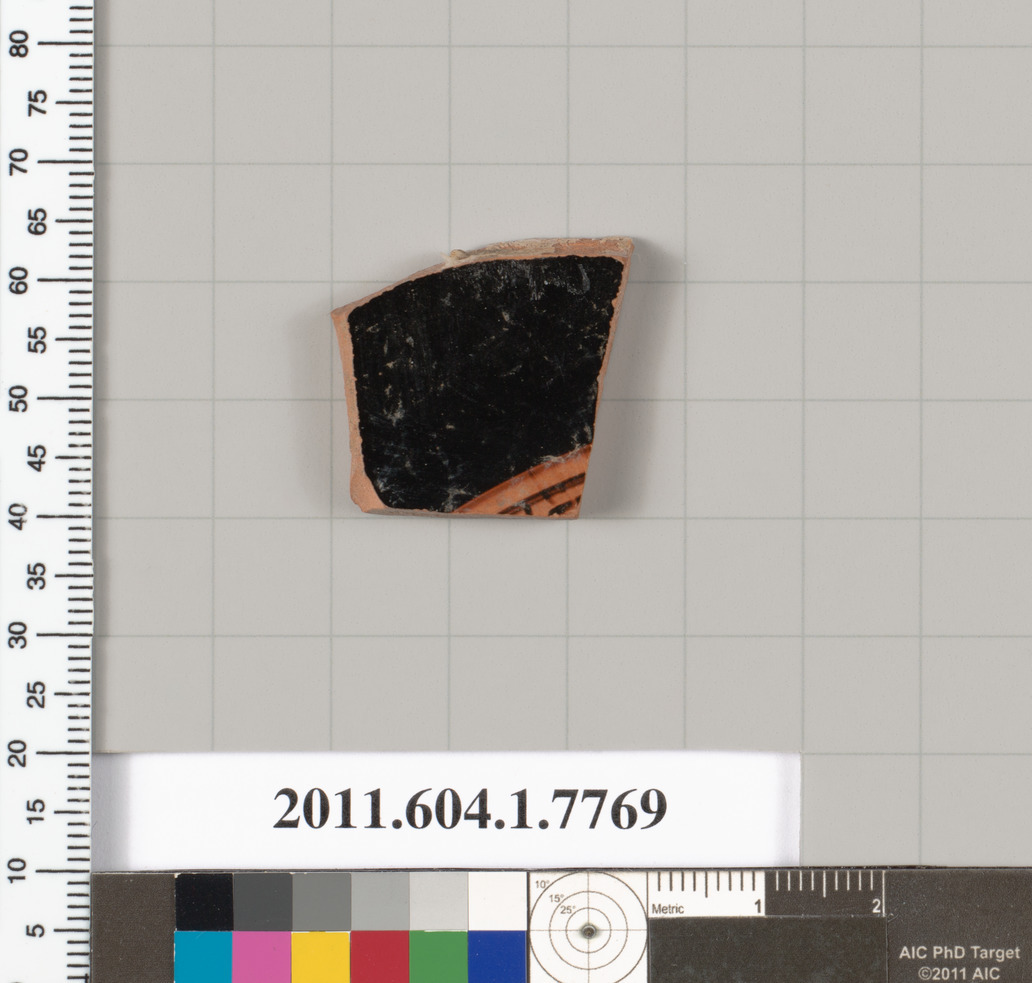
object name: kylix fragment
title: Terracotta fragment of a kylix (drinking cup)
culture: greek, attic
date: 460-450 BCE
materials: terracotta